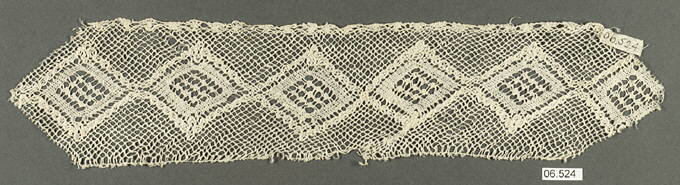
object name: fragment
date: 1801-1833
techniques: lace